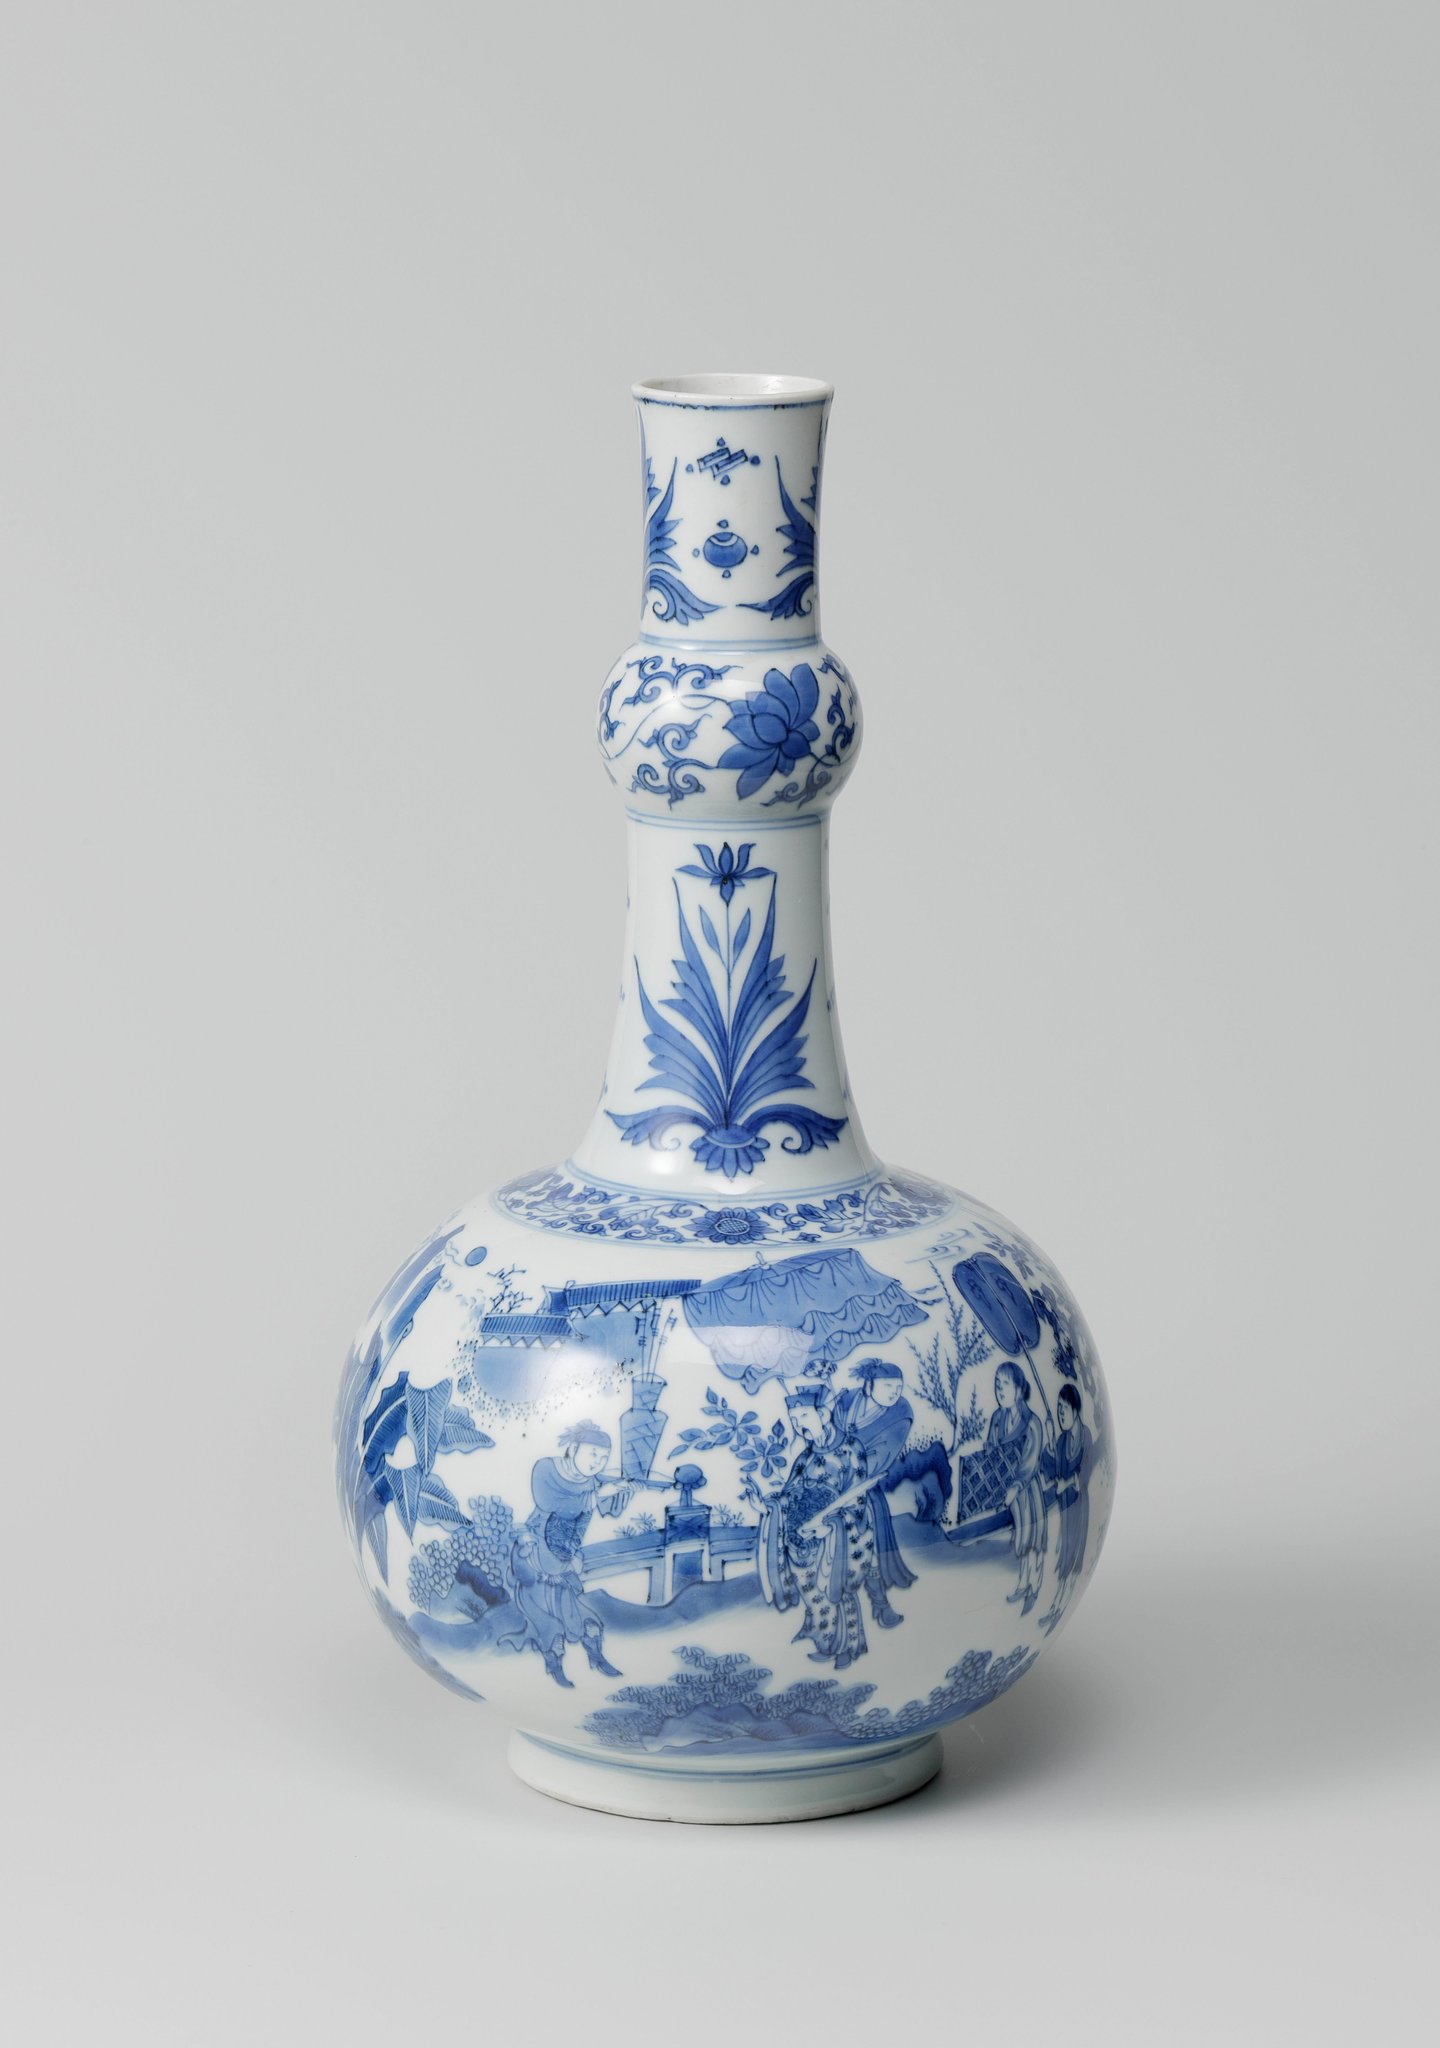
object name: bottle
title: Round-bodied bottle vase with figures in a landscape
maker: Anonymous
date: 1635-1645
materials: cobalt, glaze, paint, porcelain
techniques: firing, turning, vitrification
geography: china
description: Flesvormige vaas (knobbelfles) van porselein met een ringvormige verdikking in de nek, beschilderd in onderglazuur blauw. Op de wand een doorlopende voorstelling van een hoogwaardigheidsbekleder en zijn gevolg op een omheind terras in een landschap met bergen, bomen en planten (bananenplant). Een persoon biedt de hoogwaardheidsbekleder een vaas aan. Het tafereel wordt afgesloten door wolken en rotsen. De schouder met een band met bloemranken. Op de hals tweemaal een tulpmotief met daartussen telkens drie kostbaarheden (hoorn, boeken, munt). De ringvormige verdikking met lotusranken. Daarboven nogmaals het tulpmotief en kostbaarheden (boeken, parel). Overgangsporselein in blauw-wit.